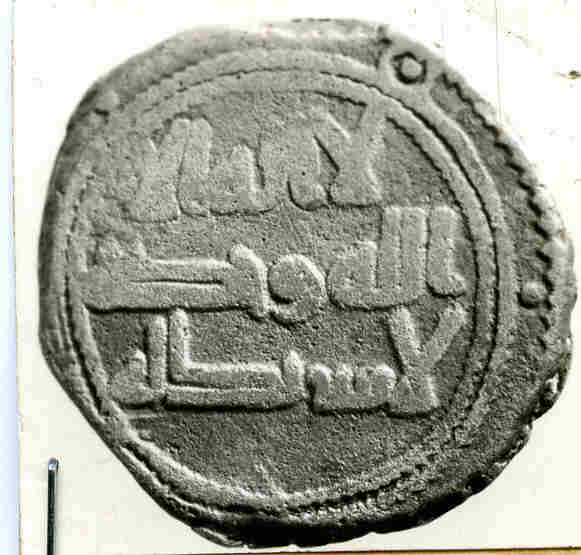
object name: coin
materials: copper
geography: iran